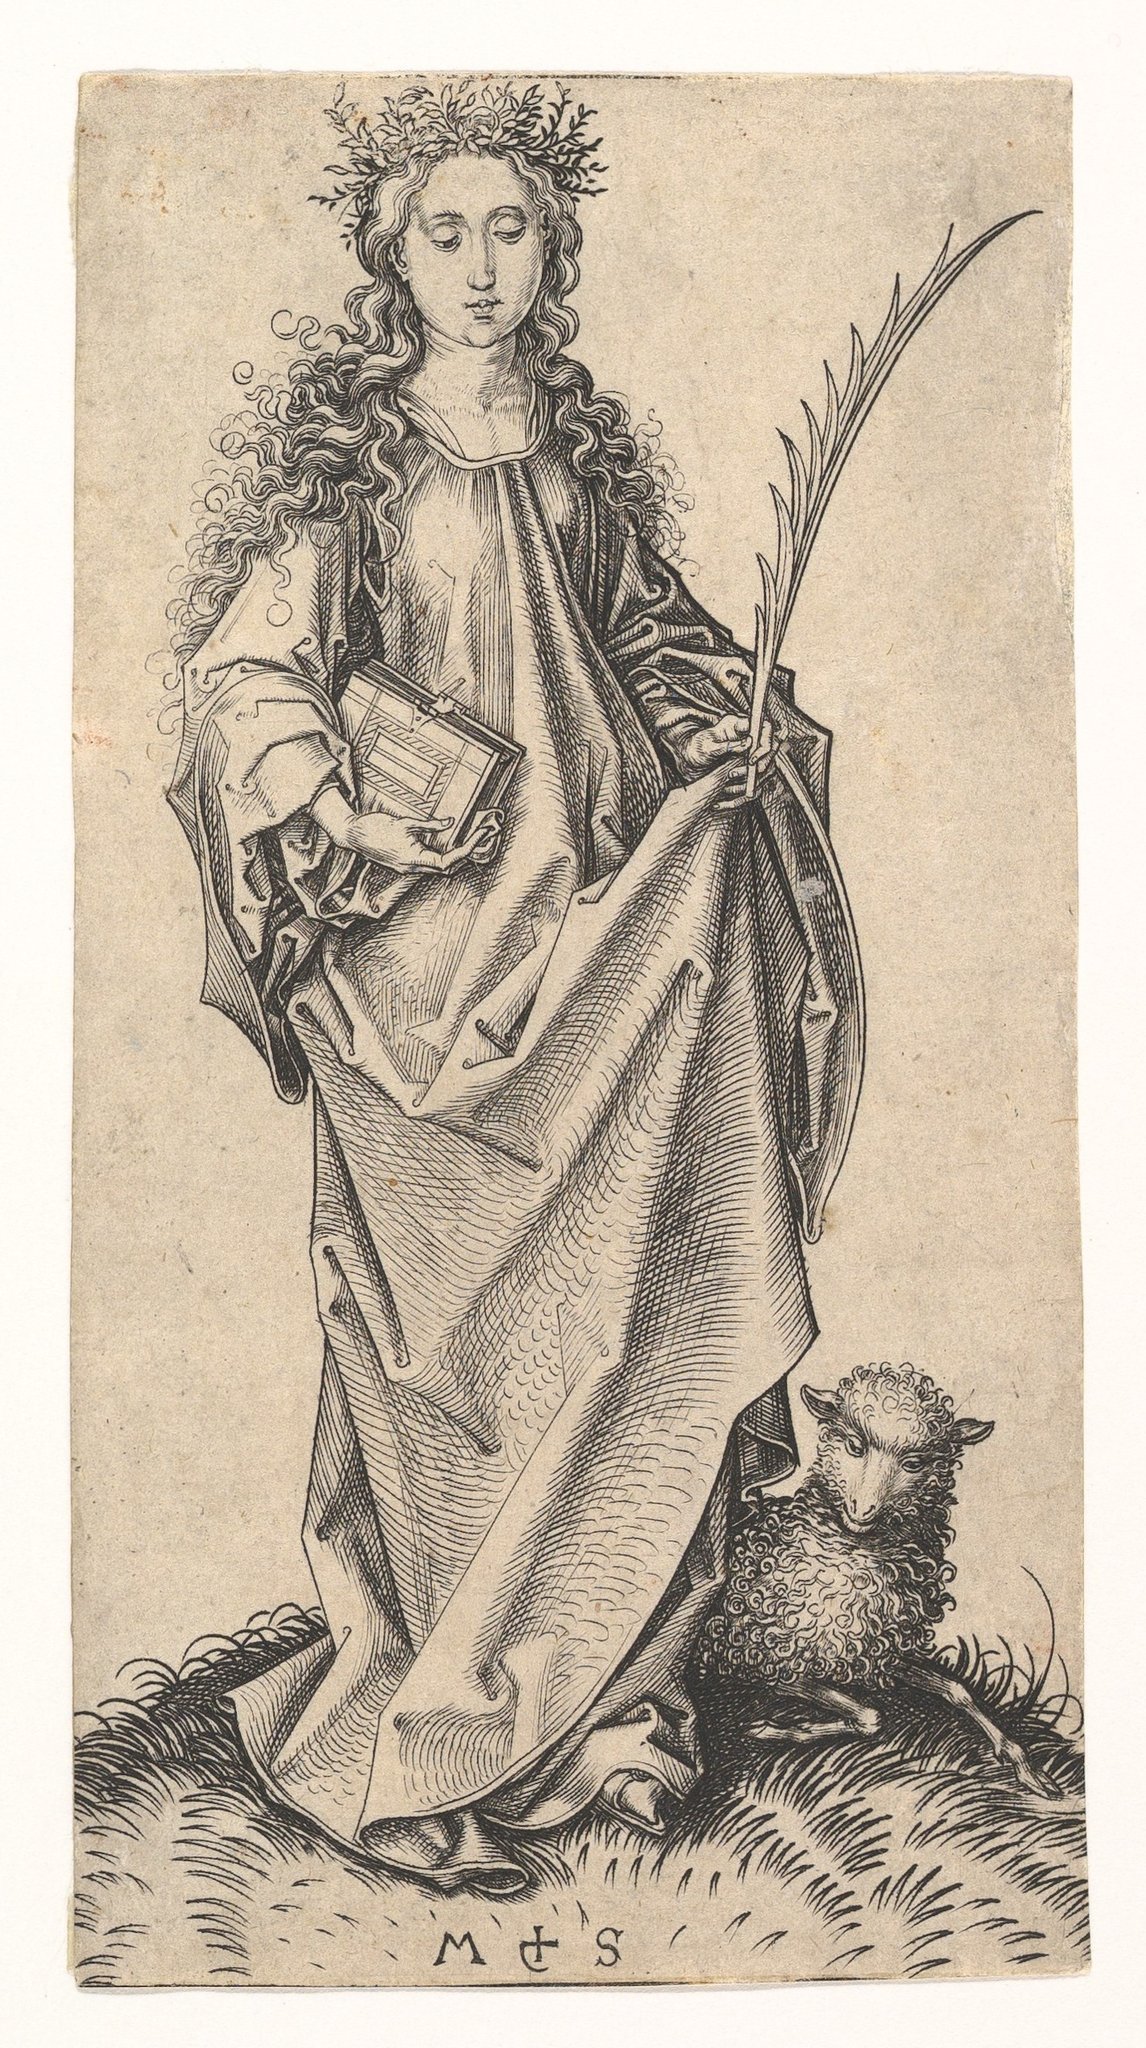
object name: print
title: St. Agnes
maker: martin schongauer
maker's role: artist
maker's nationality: german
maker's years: 1430-1491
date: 1470-1491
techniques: engraving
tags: sheep,plants,saints